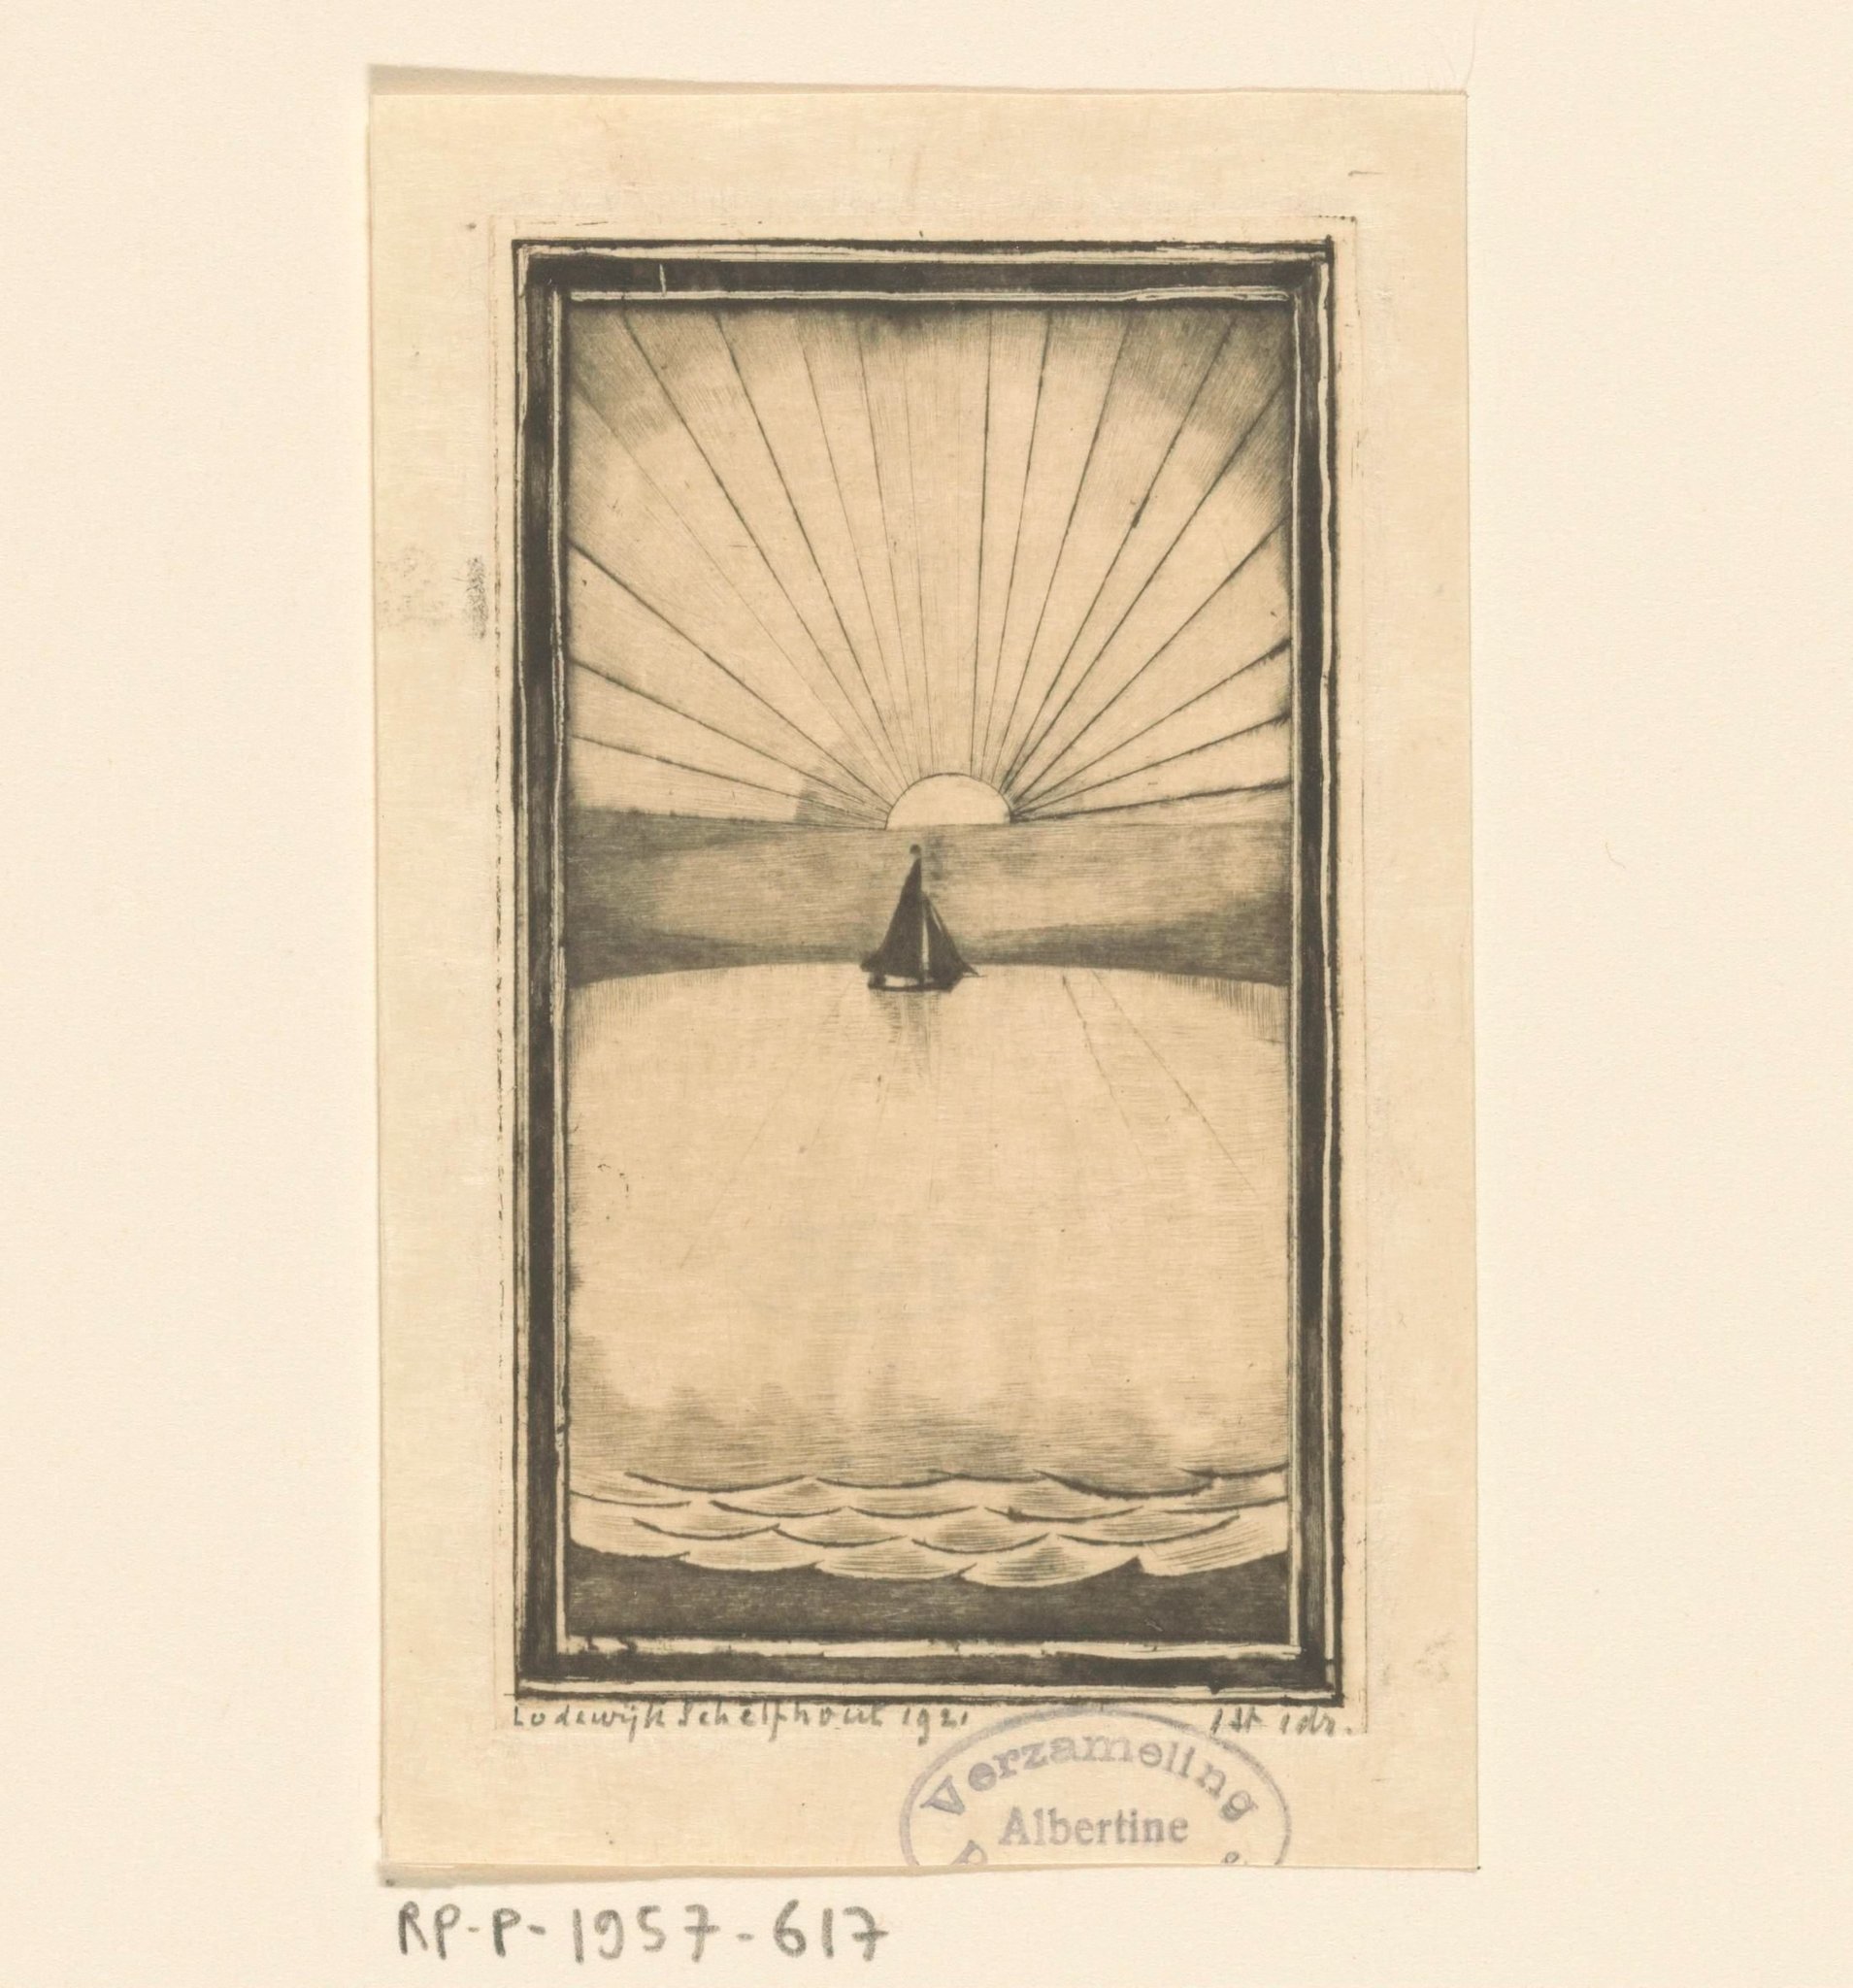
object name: print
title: Zeilschip op zee bij opgaande of ondergaande zon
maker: lodewijk schelfhout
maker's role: draughtsman, print maker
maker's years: 1881-1943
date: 1921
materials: paper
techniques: drypoint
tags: sailing-ship, sailing-boat, sun as celestial body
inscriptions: collector's mark: Lugt 5i, collector's mark: Lugt 2228